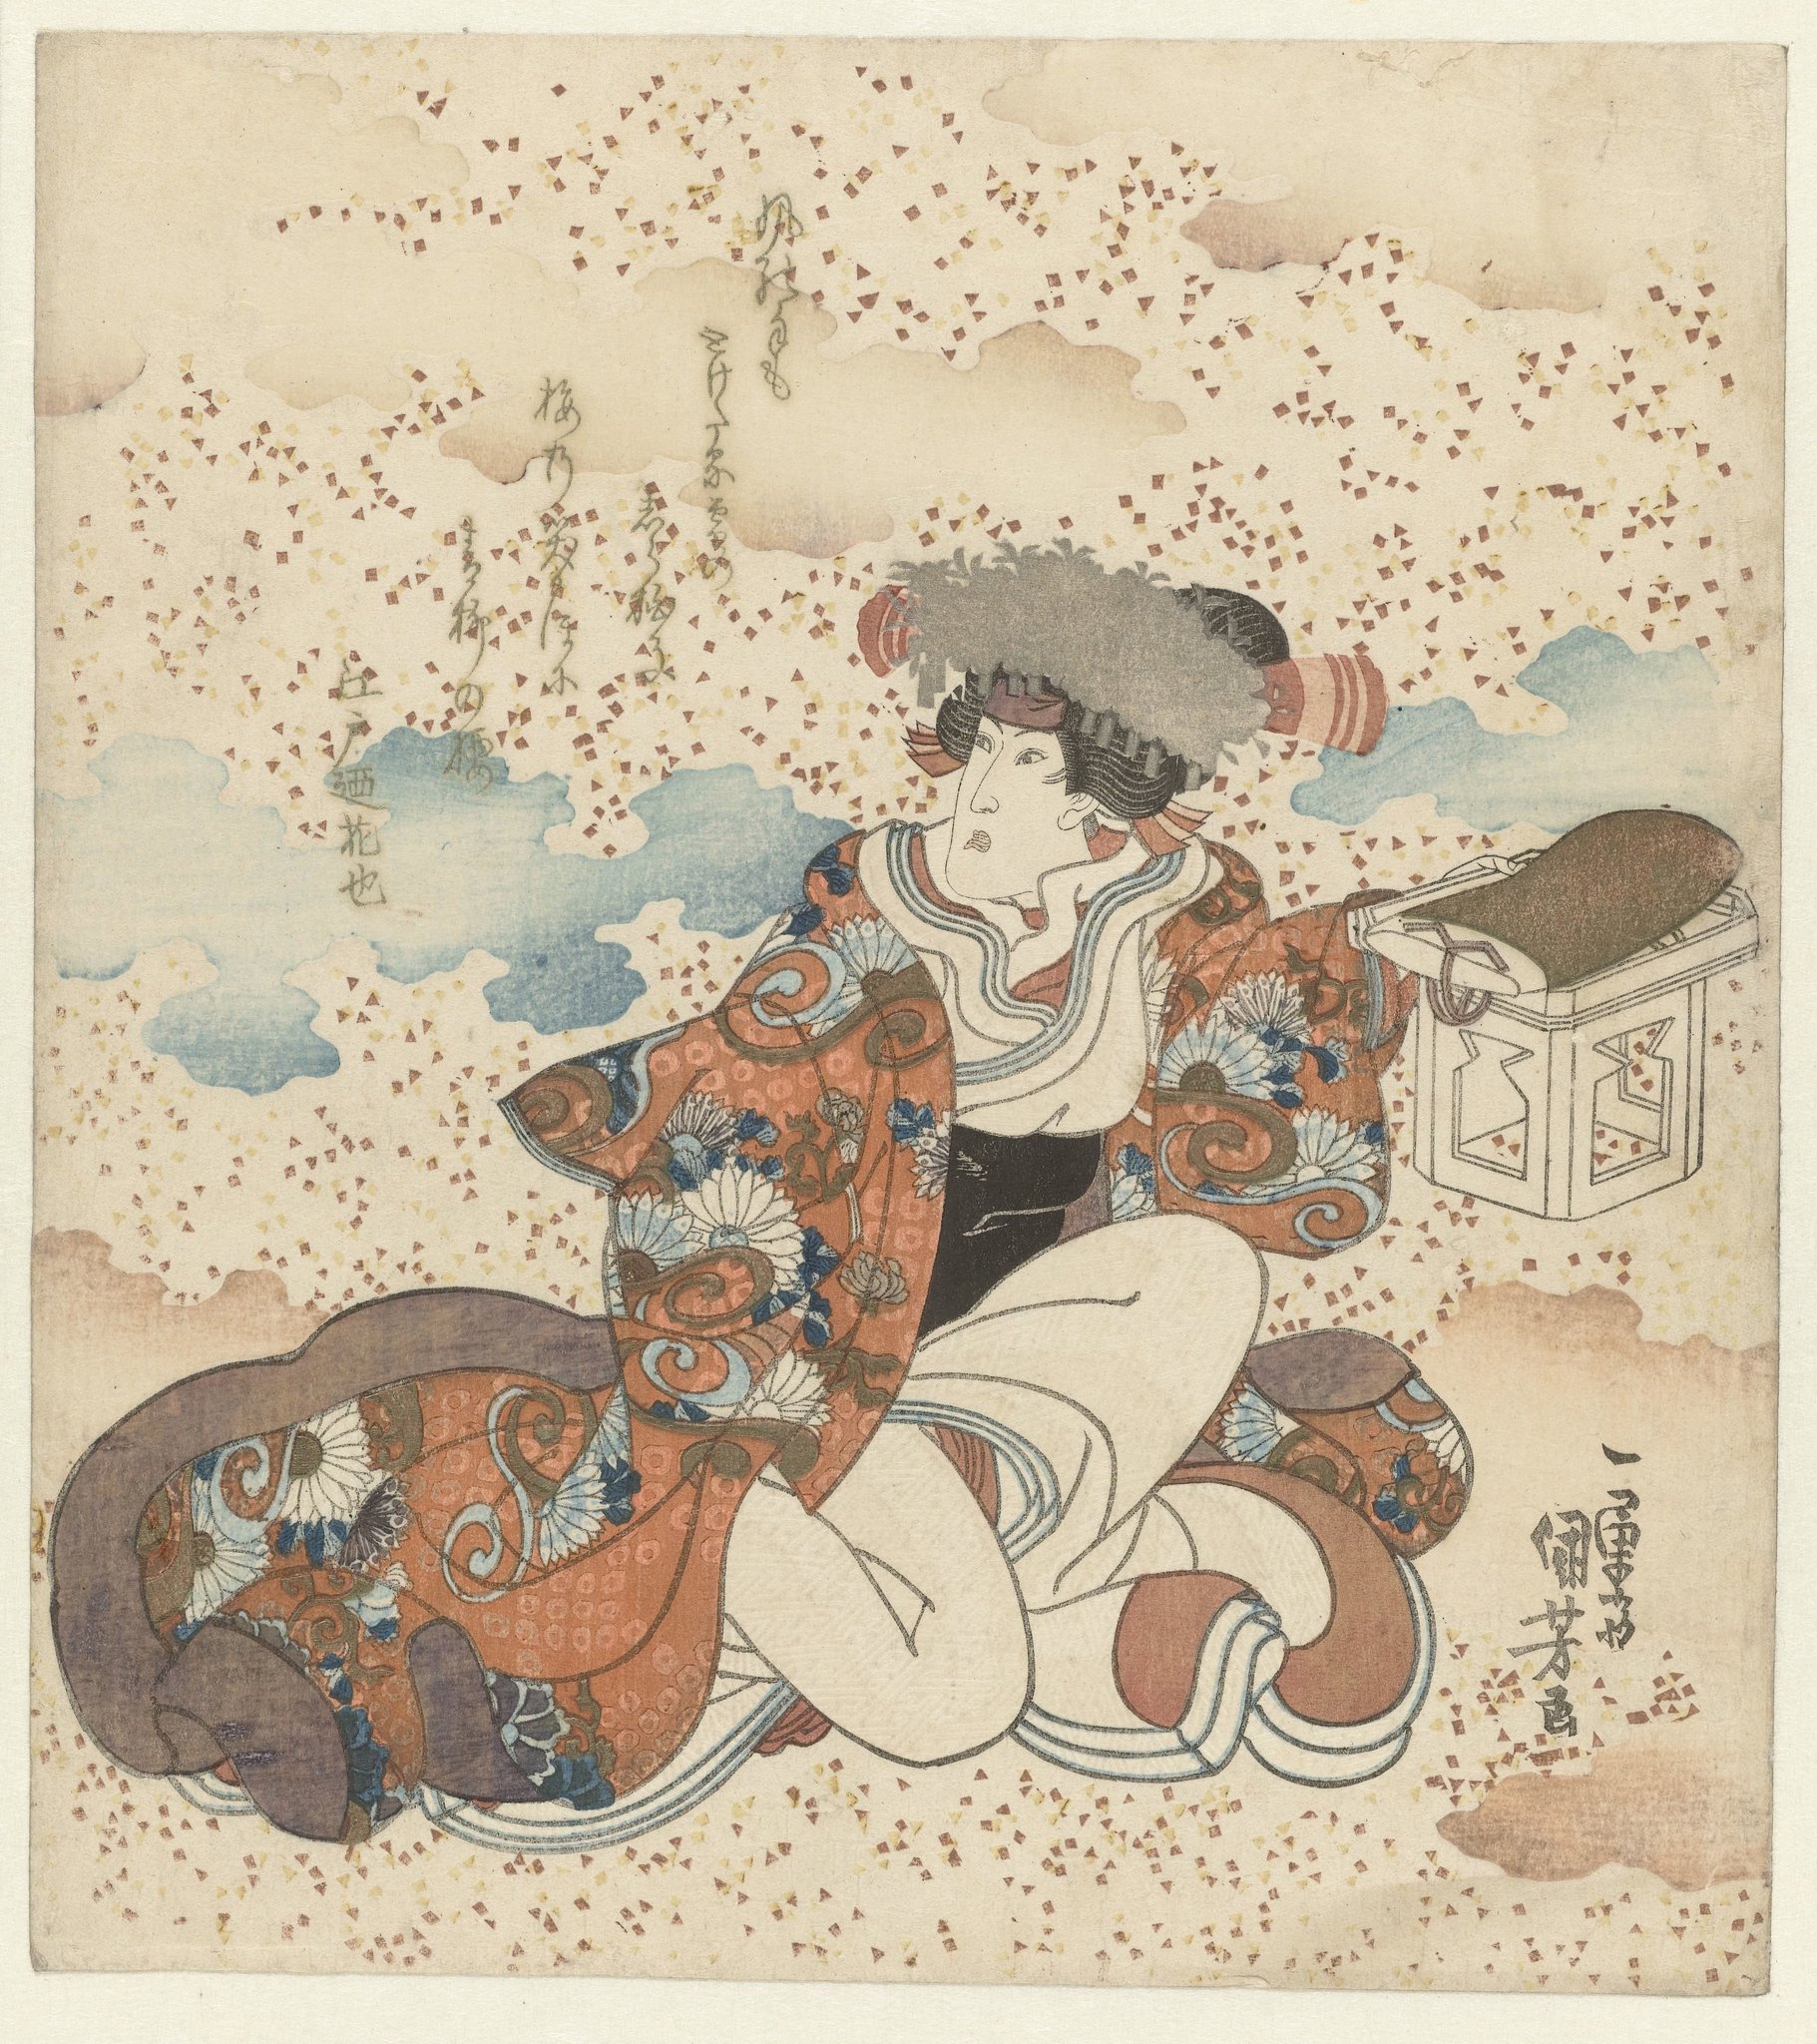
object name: surimono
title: Knielende vrouw met offertafeltje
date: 1830-1835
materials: paper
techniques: blind stamped, woodcut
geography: japan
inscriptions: collector's mark, verso, stamped: Lugt 2228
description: Een surimono is een luxe uitgevoerde prent waarop beeld met één of meerdere gedichten gecombineerd is. Bij het drukken van een surimono werd vaak gebruik gemaakt van dikker papier, blinddruk en metaal pigmenten, zoals koper- en zilverpoeder. De prenten werden vaak in opdracht van dichters gemaakt en als exclusief geschenk aan vrienden en relaties gegeven.